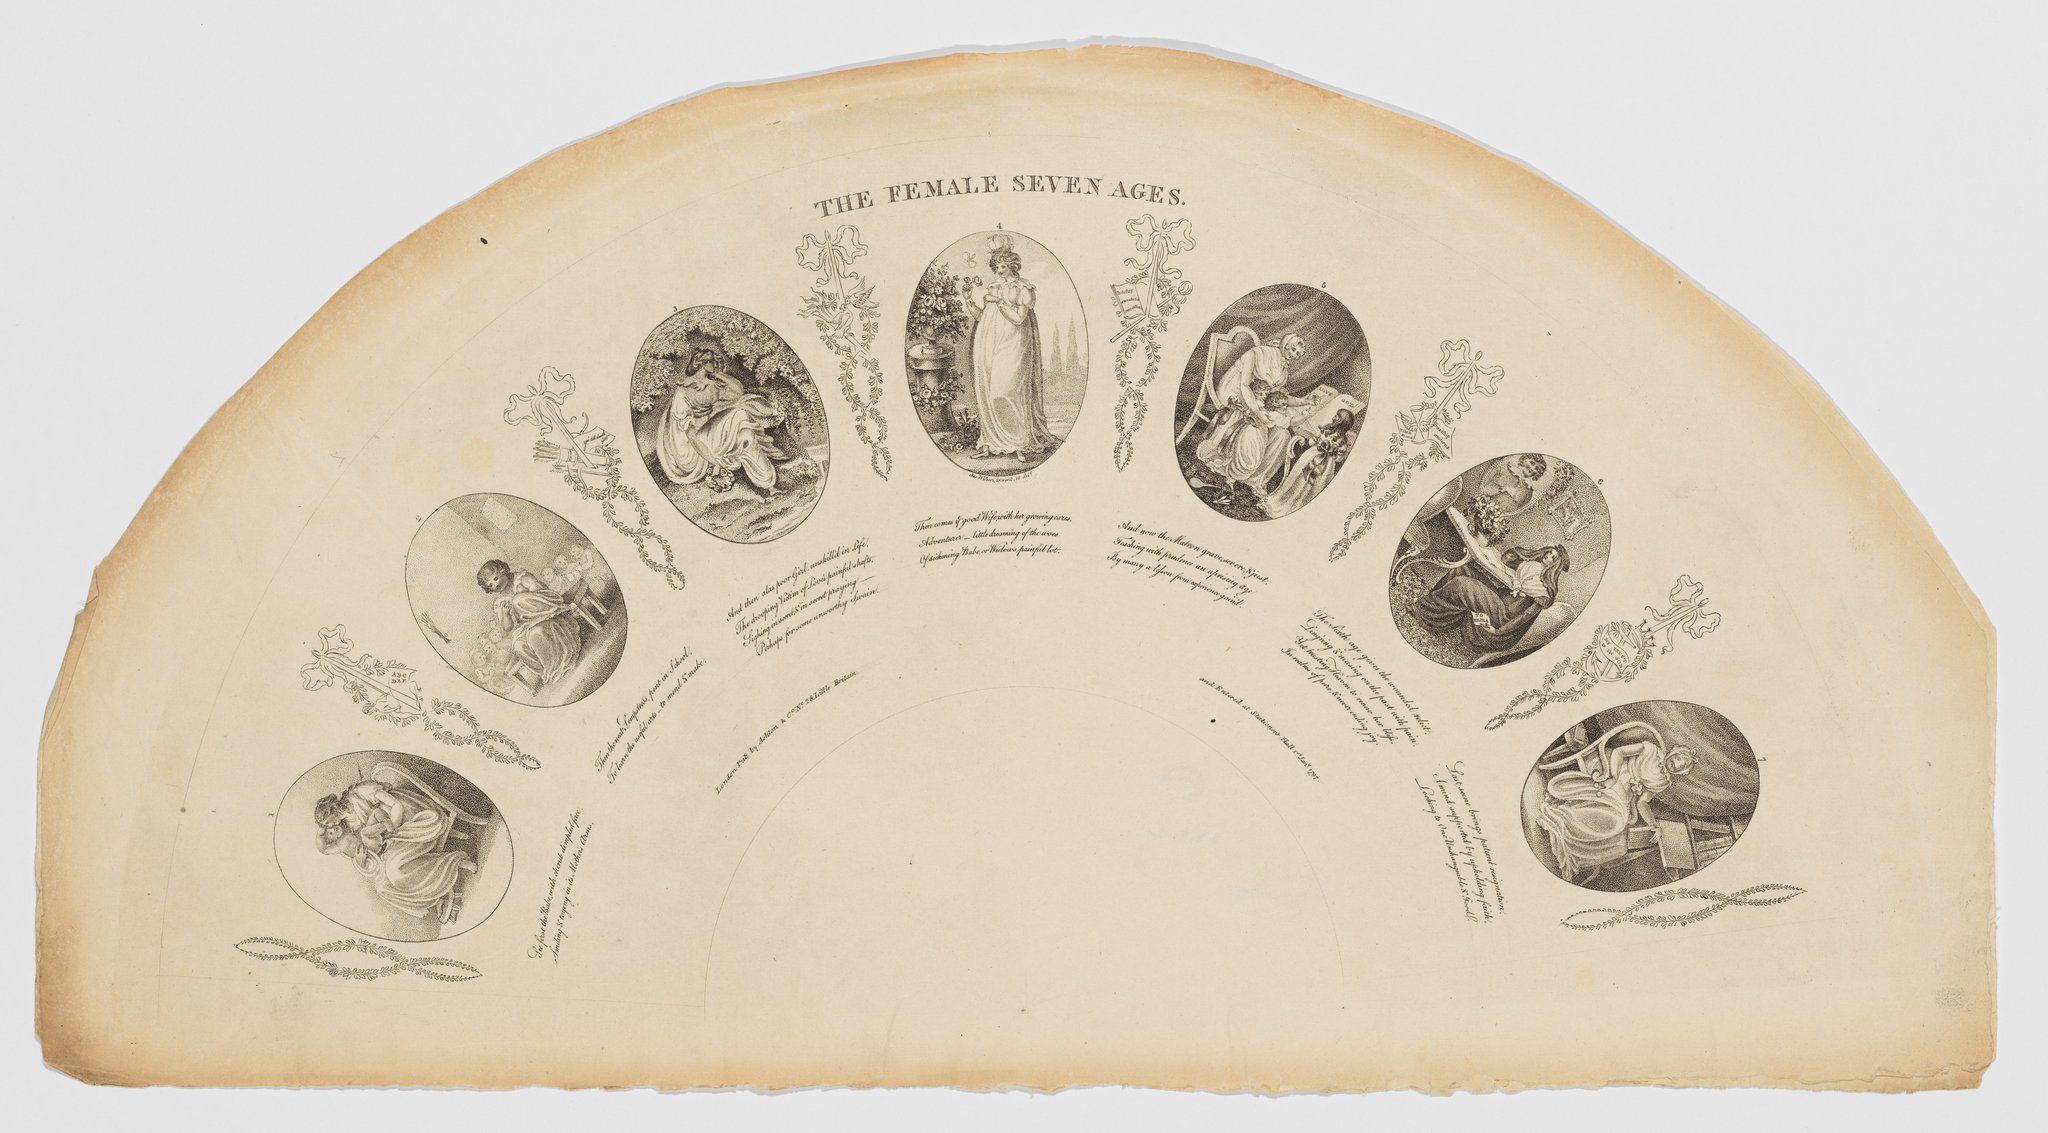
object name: print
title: The Female Seven Ages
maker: george wilson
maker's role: artist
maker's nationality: british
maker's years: 1795-1801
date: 1797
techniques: engraving